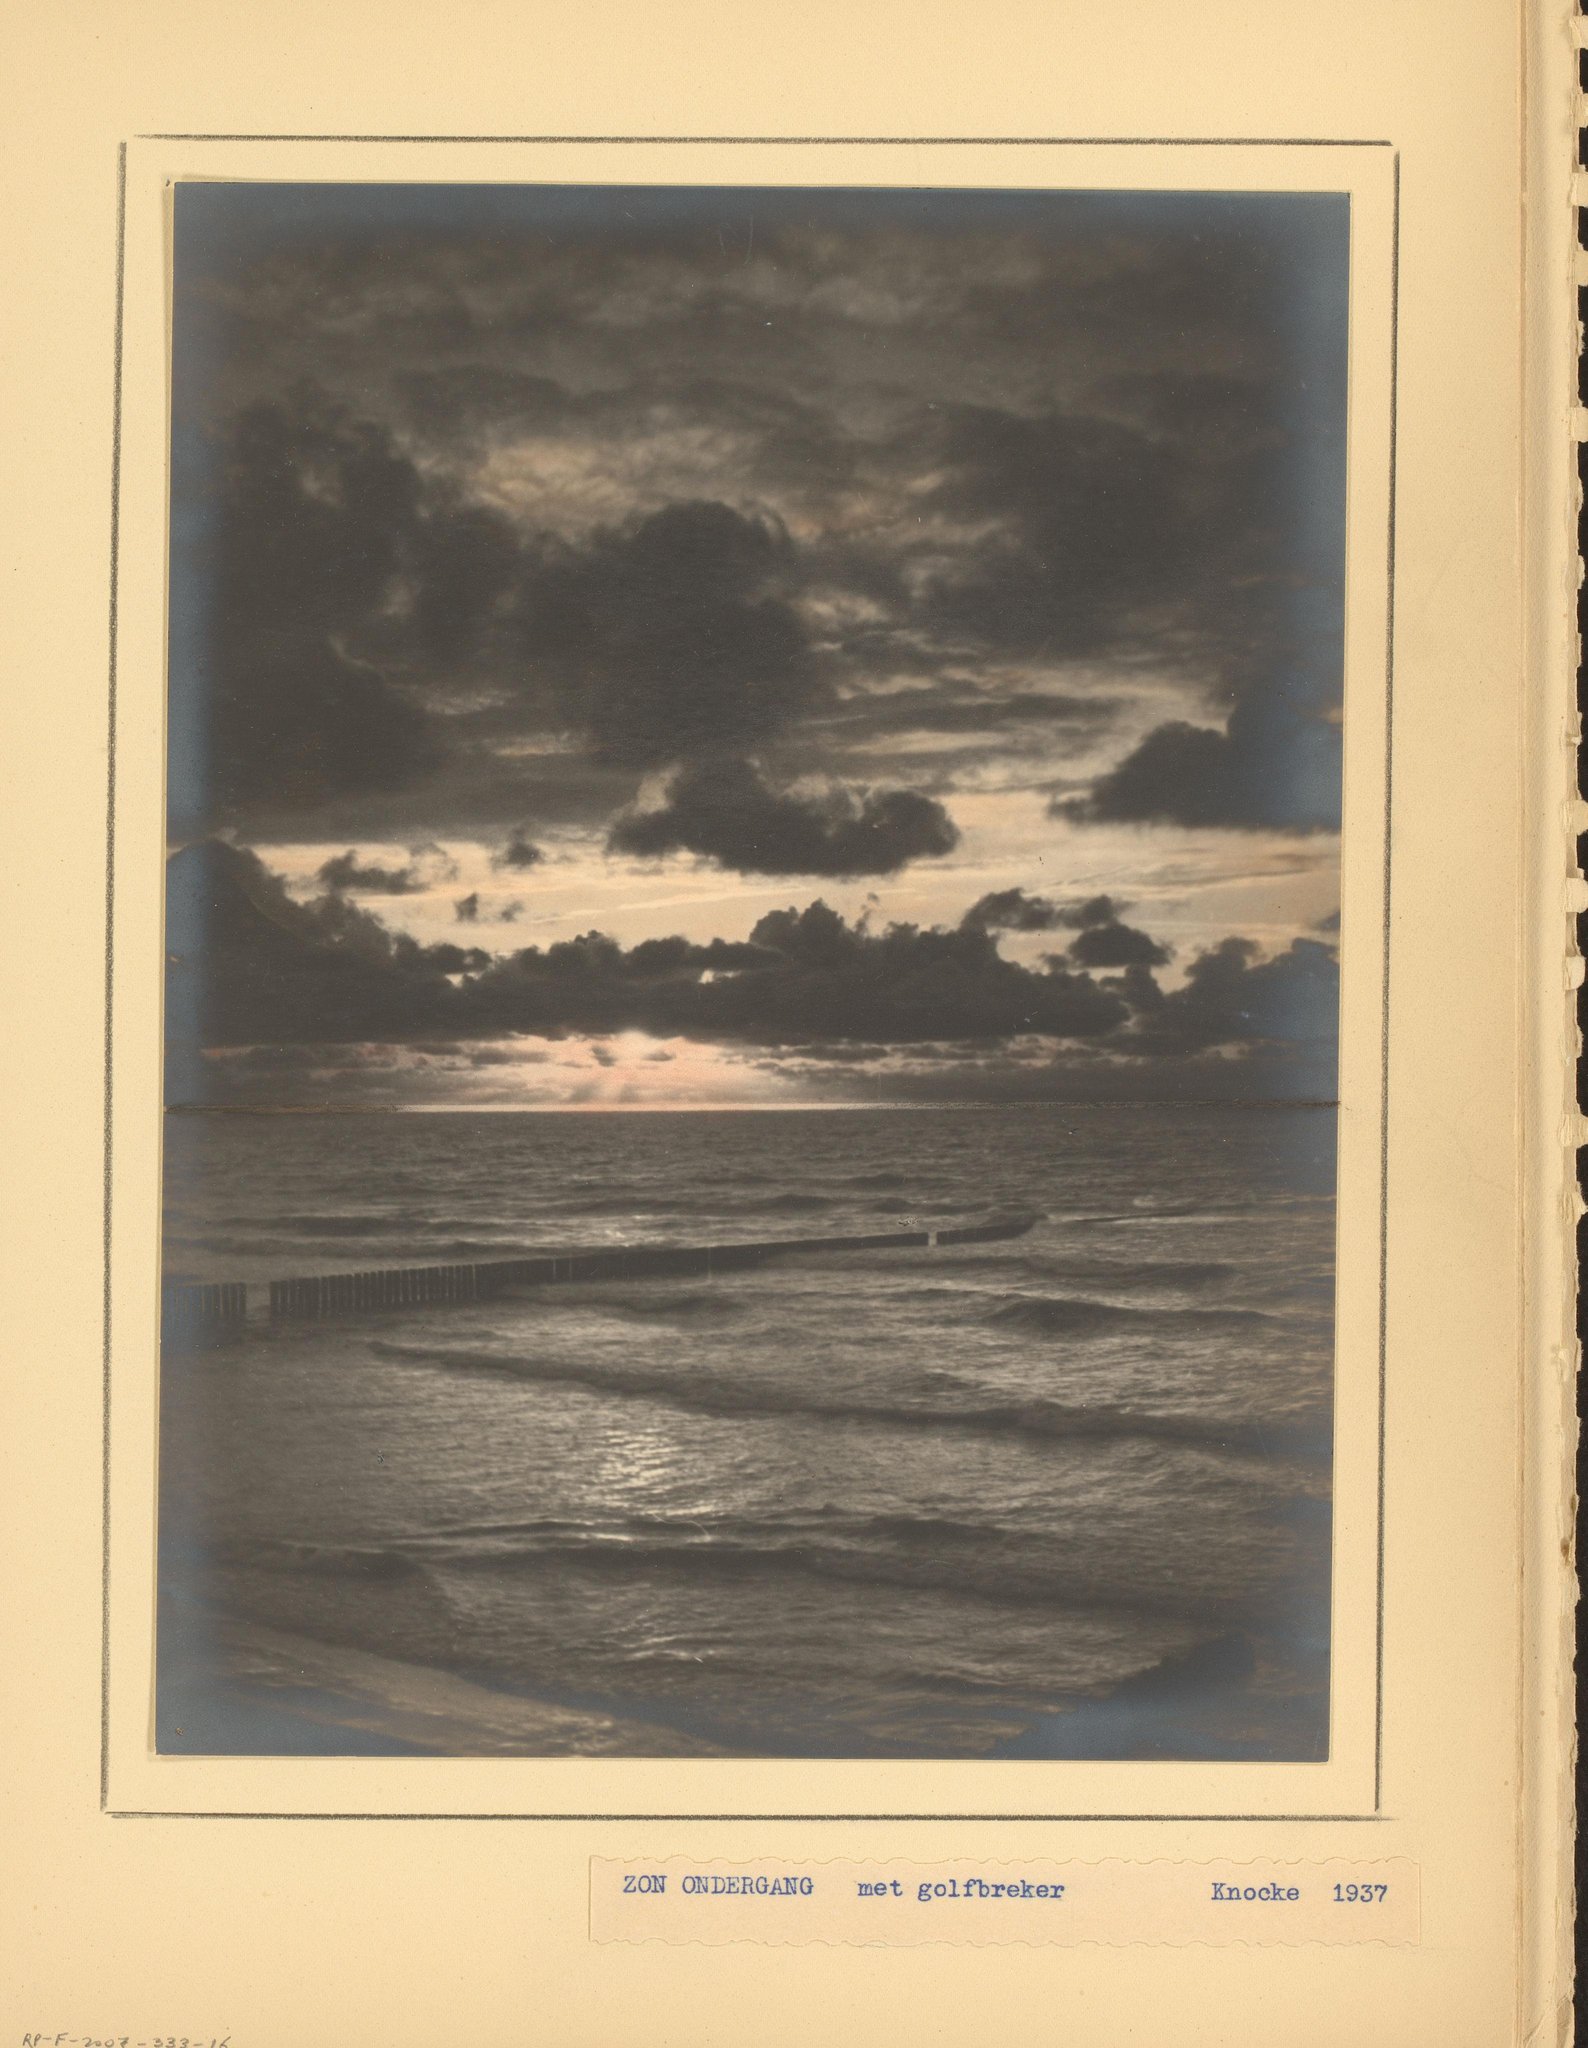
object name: photograph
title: Zonsondergang in Knokke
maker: gerrit elink schuurman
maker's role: fotograaf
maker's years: 1876-1953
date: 1937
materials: paper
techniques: gelatin silver print, hand coloring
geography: knokke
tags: sea (seascape), coastal protection work, breakwater, sunset